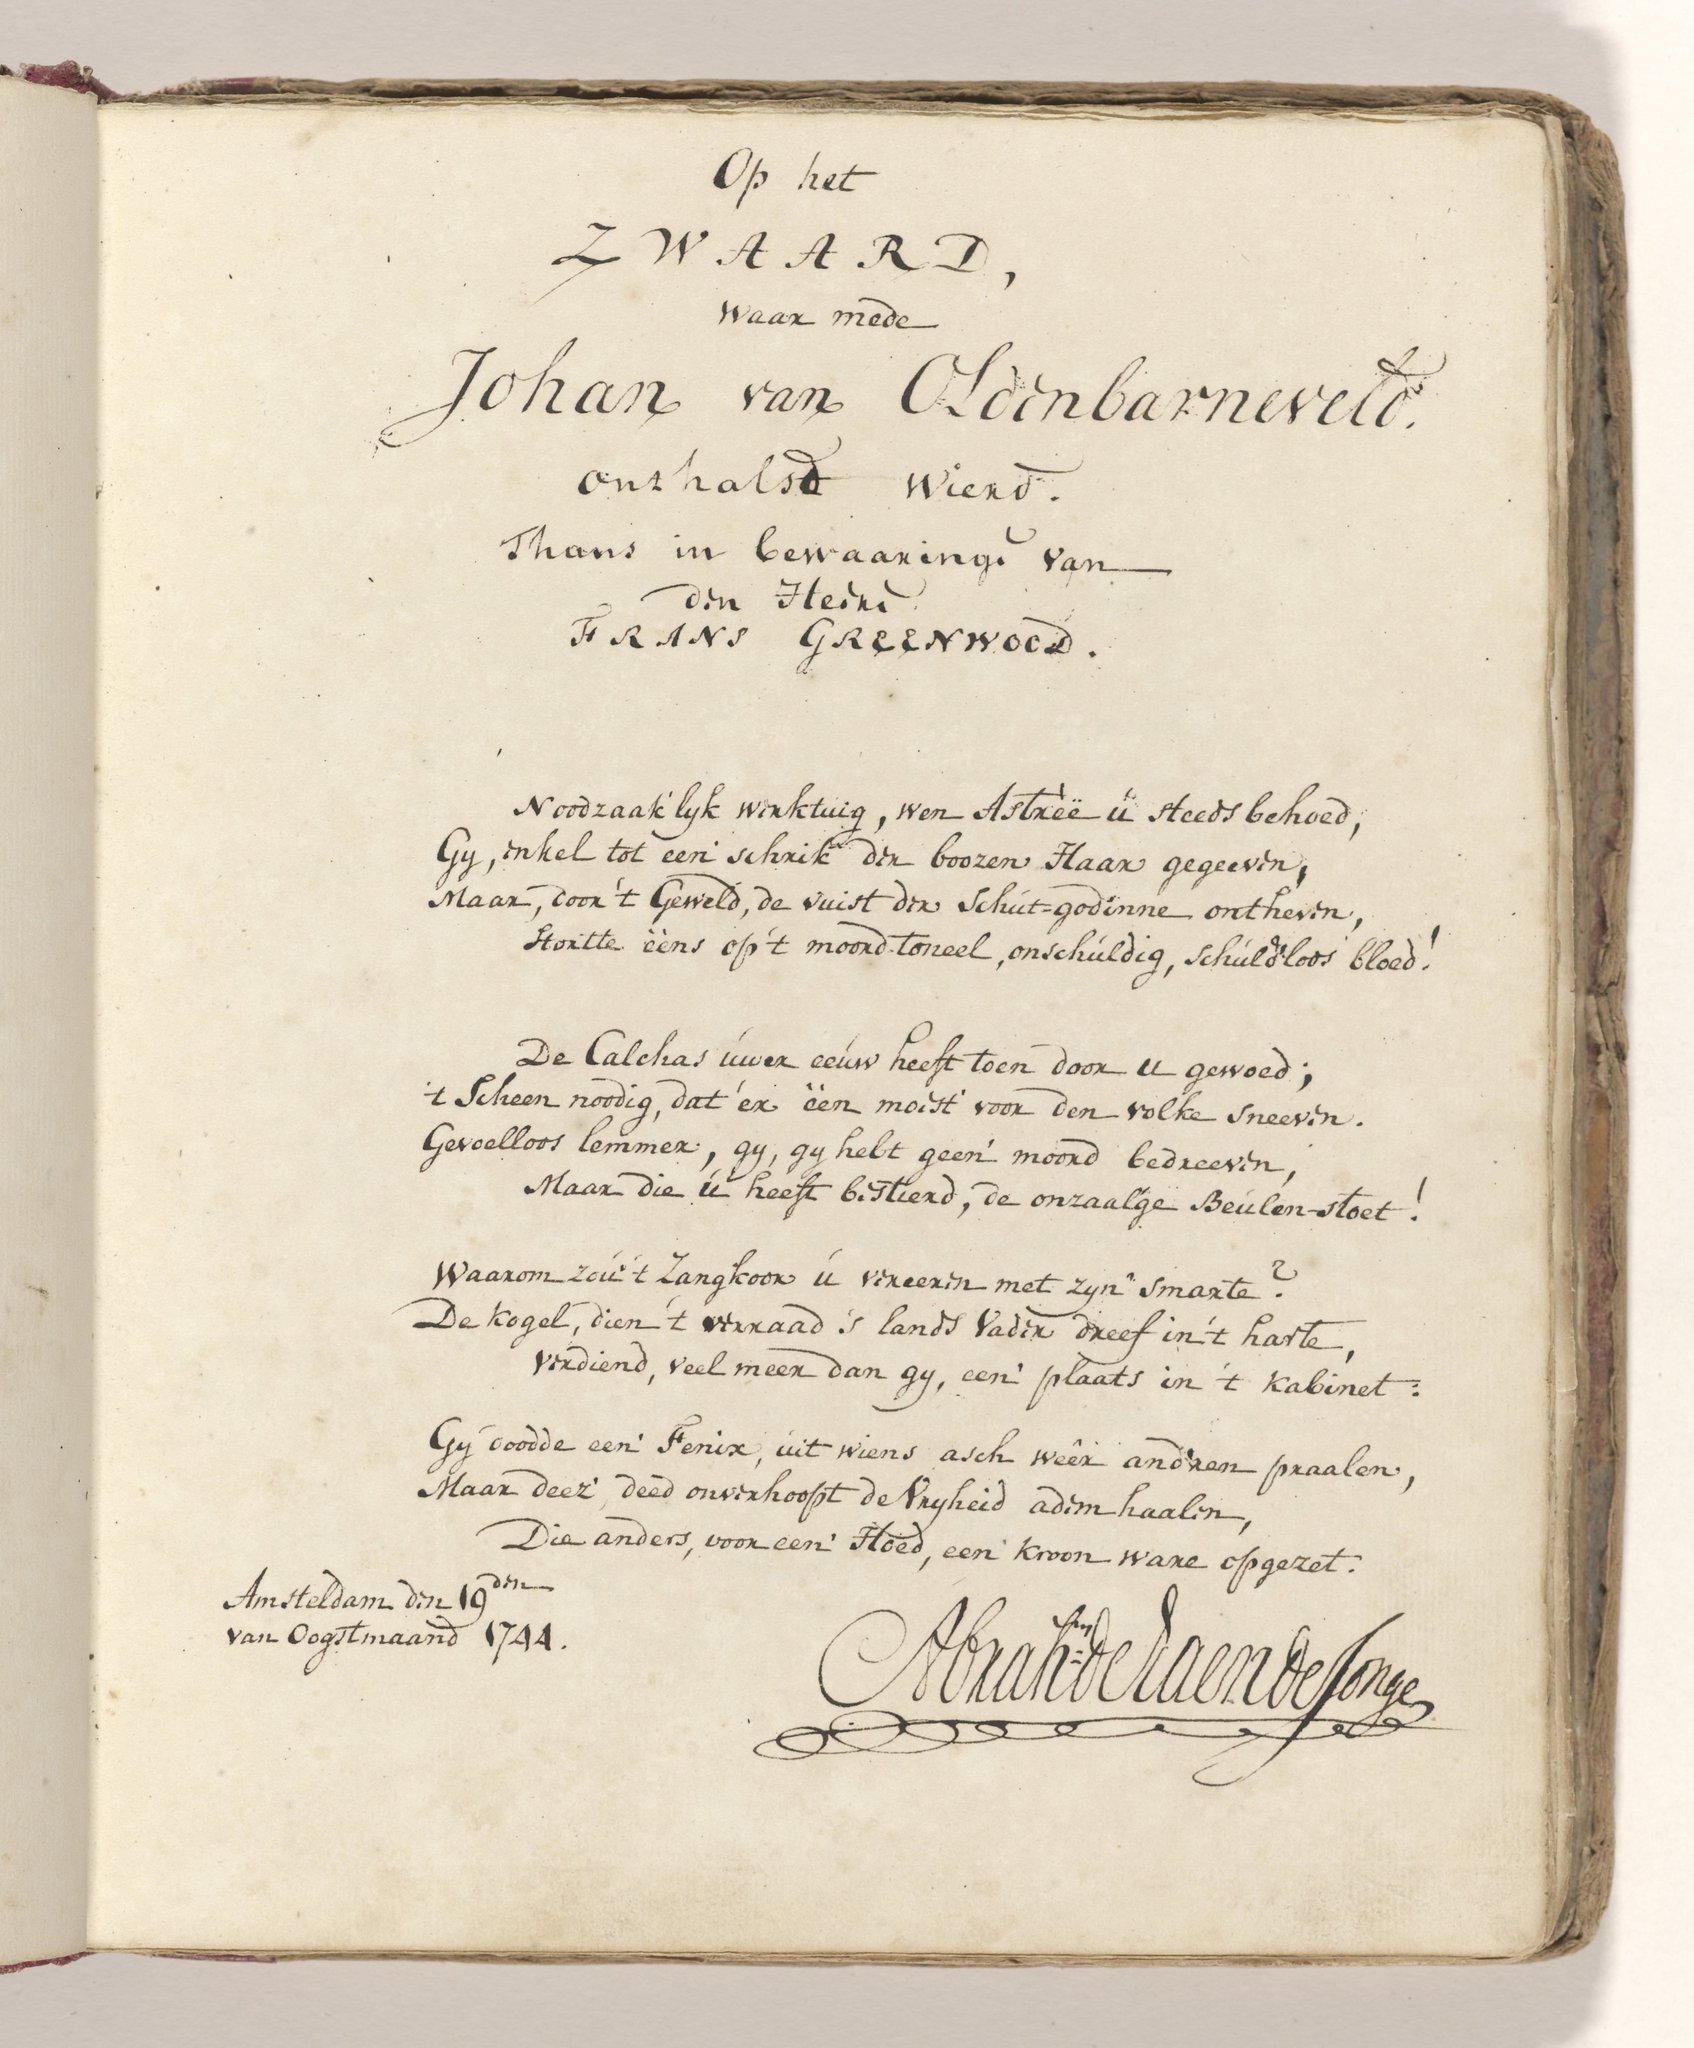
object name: manuscript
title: Gedicht op het zwaard waarmee Johan van Oldenbarnevelt in 1619 zou zijn onthoofd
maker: abraham de haen (ii)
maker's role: draughtsman, print maker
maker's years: 1707-1748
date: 1744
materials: ink, paper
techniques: writing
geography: amsterdam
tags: the hague, johan van oldenbarnevelt, frans greenwood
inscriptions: date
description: Vers van Abraham de Haen de Jonge. Onderdeel van het boek met gedichten uit de jaren 1743-1745 op het zwaard waarmee Johan van Oldenbarnevelt in 1619 zou zijn onthoofd. Het zwaard was eigendom van Frans Greenwood.